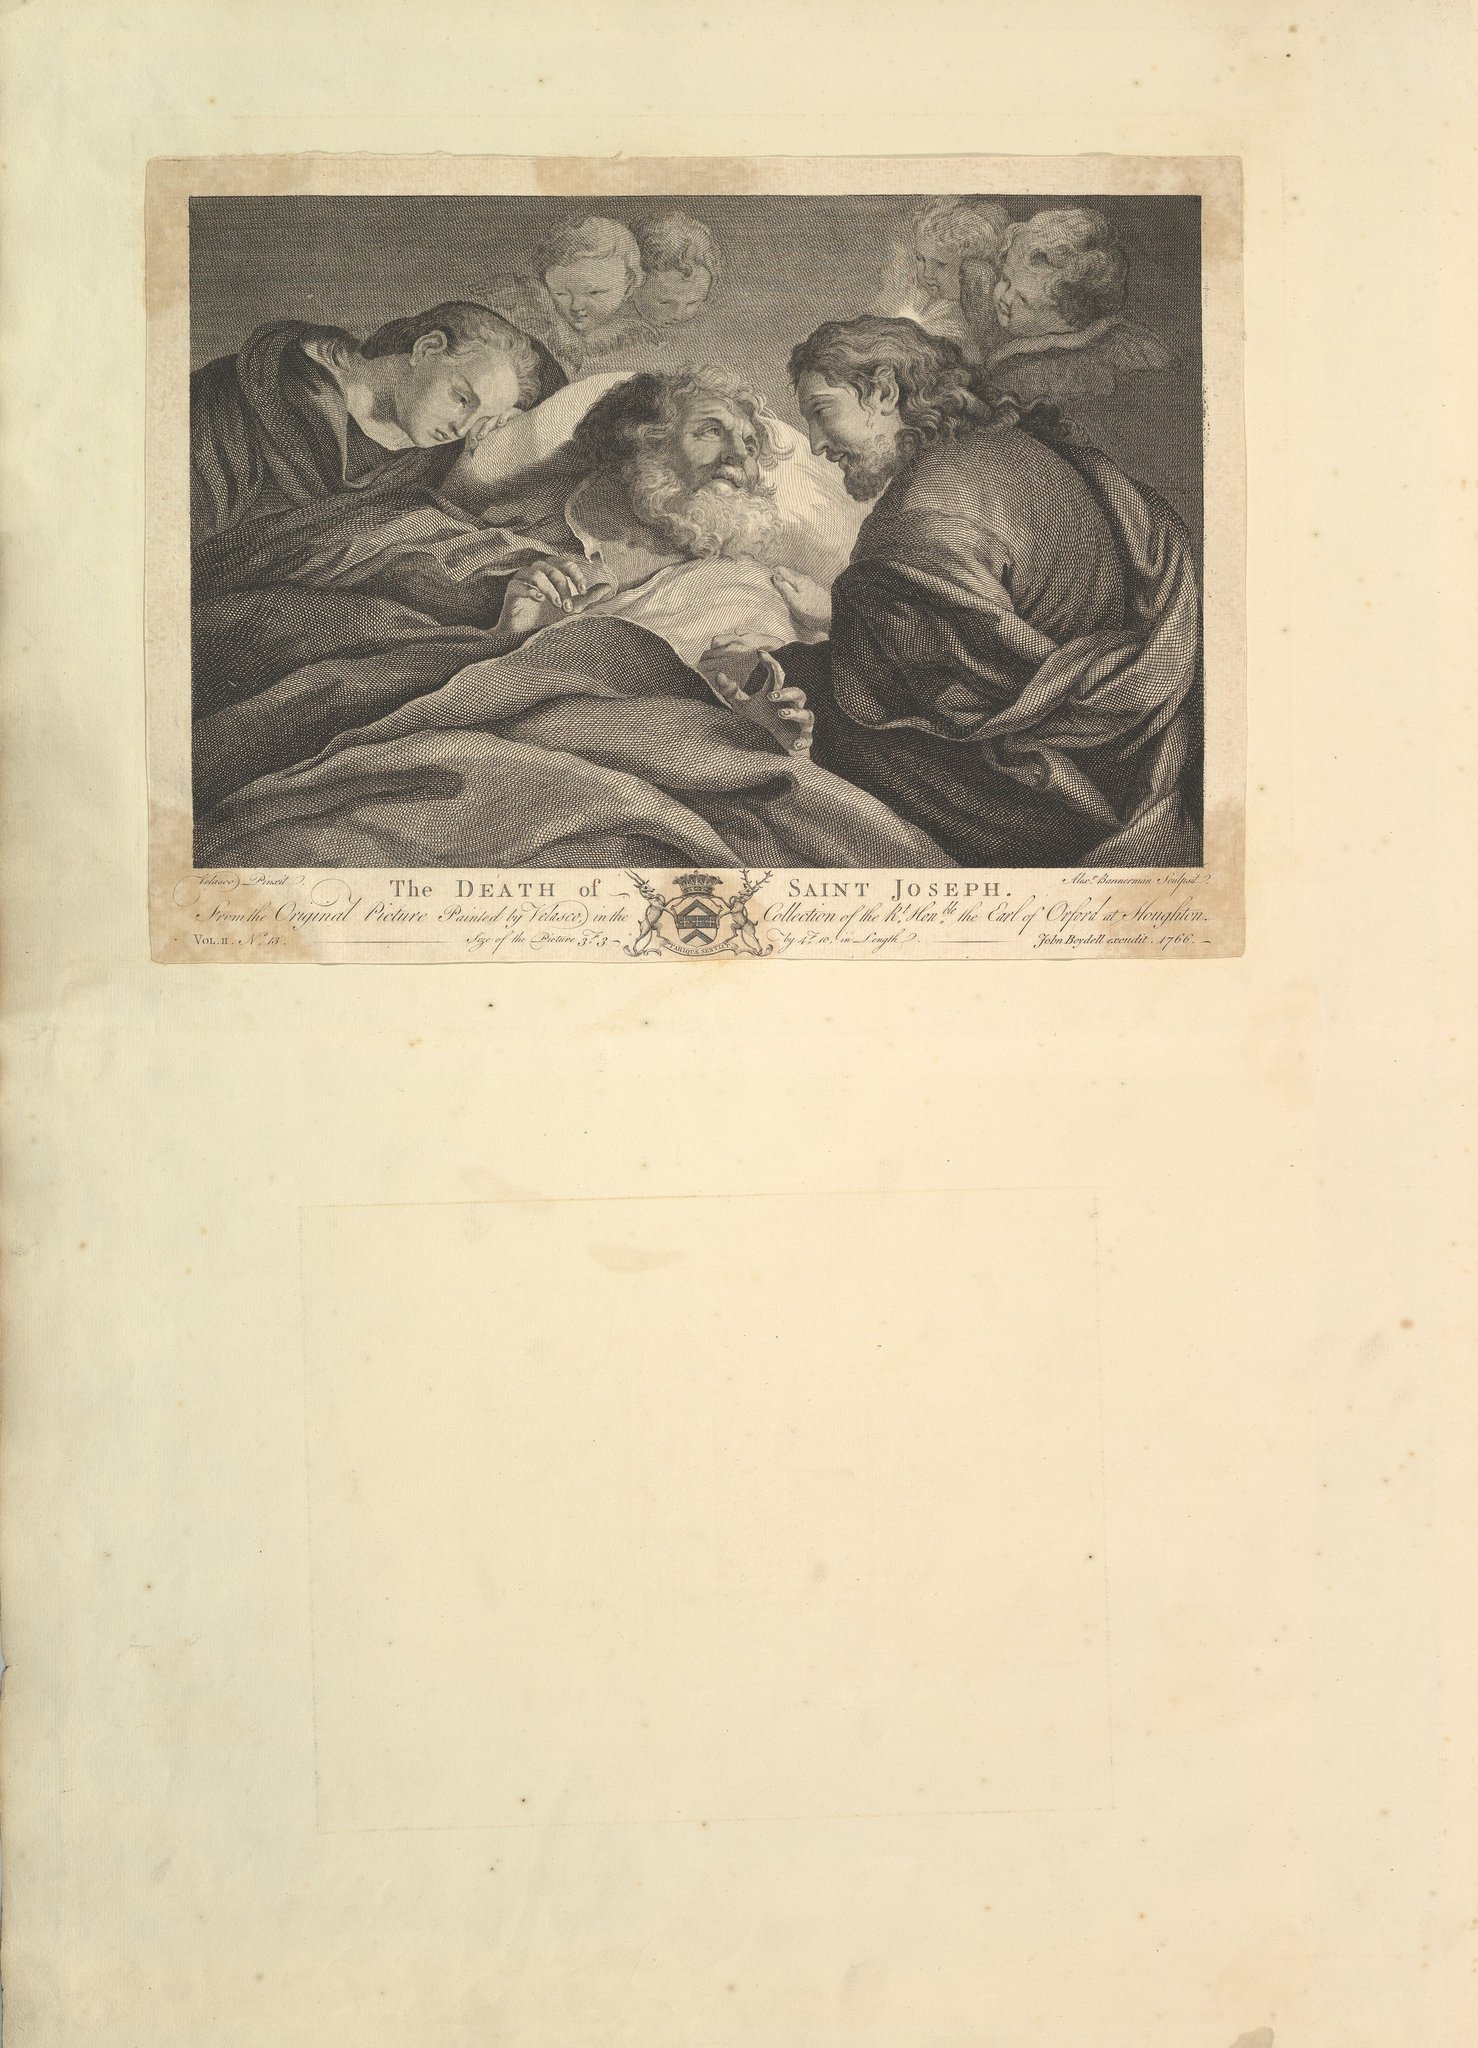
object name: print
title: The Death of St. Joseph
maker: alonso cano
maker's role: artist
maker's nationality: spanish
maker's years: 1601-1667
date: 1766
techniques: engraving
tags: men,angels,christ,saint joseph,death,coat of arms